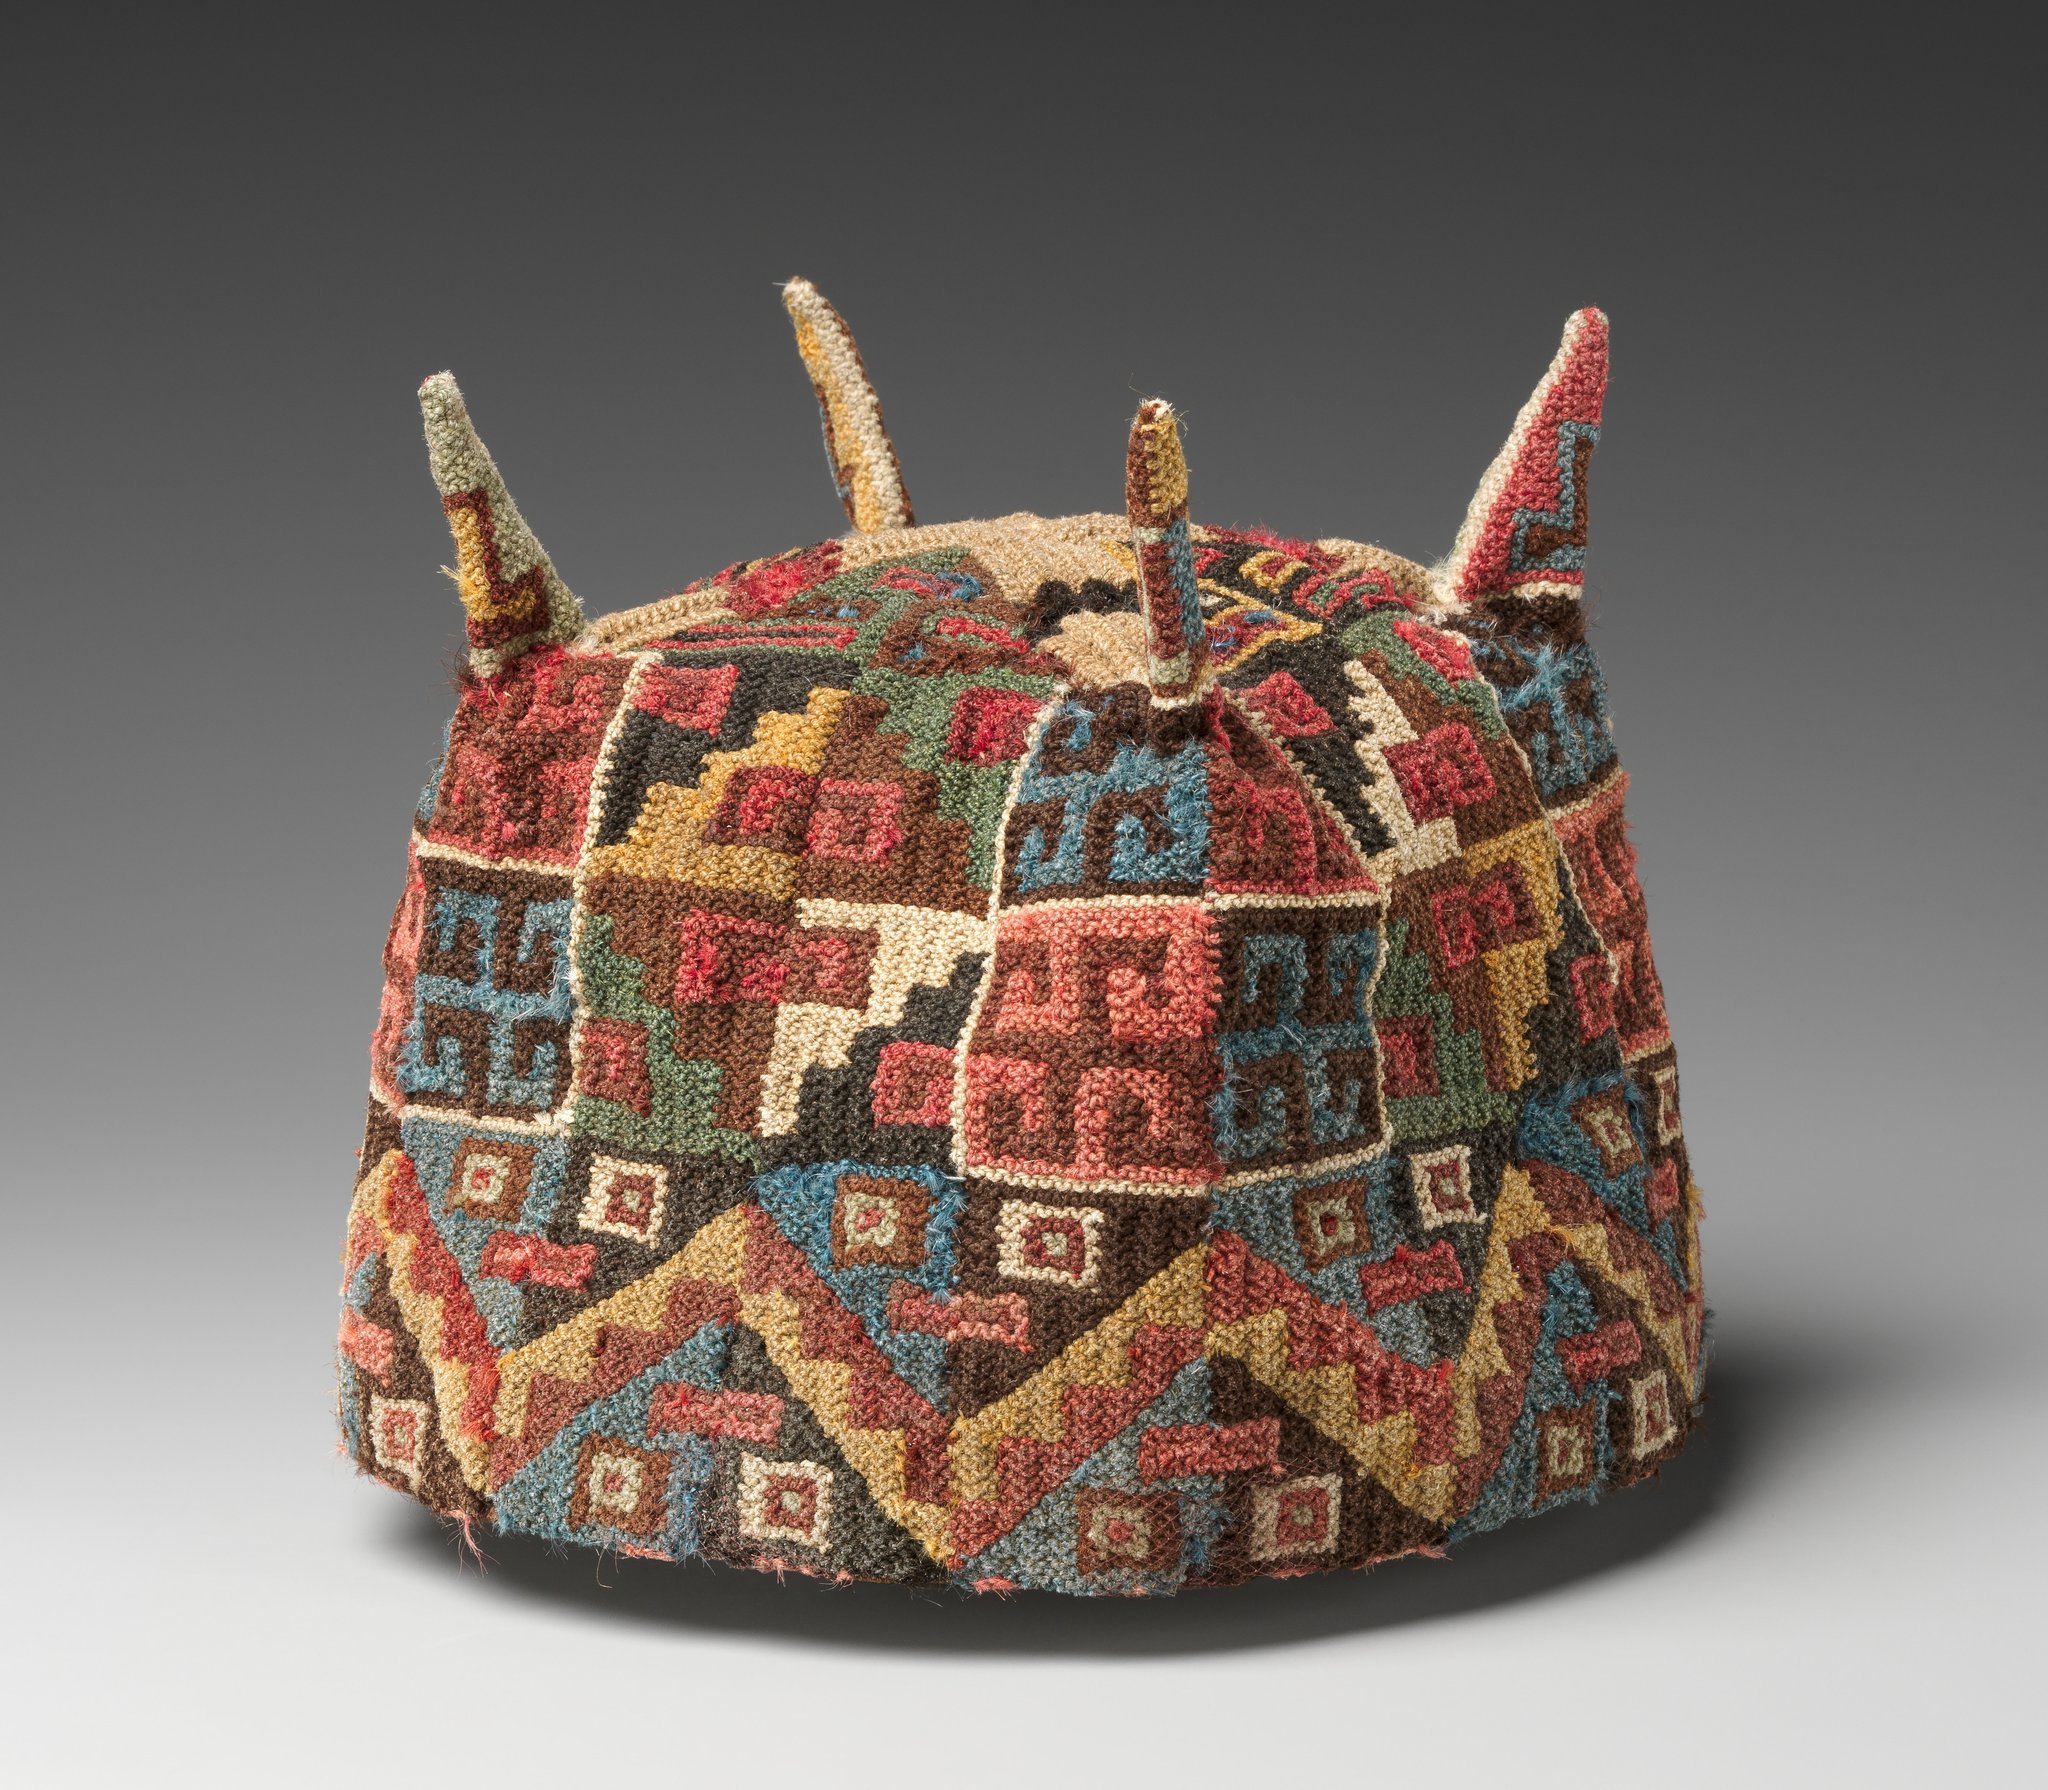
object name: hat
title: Four-Cornered Hat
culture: tiwanaku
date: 601-900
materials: animal fiber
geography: bolivia